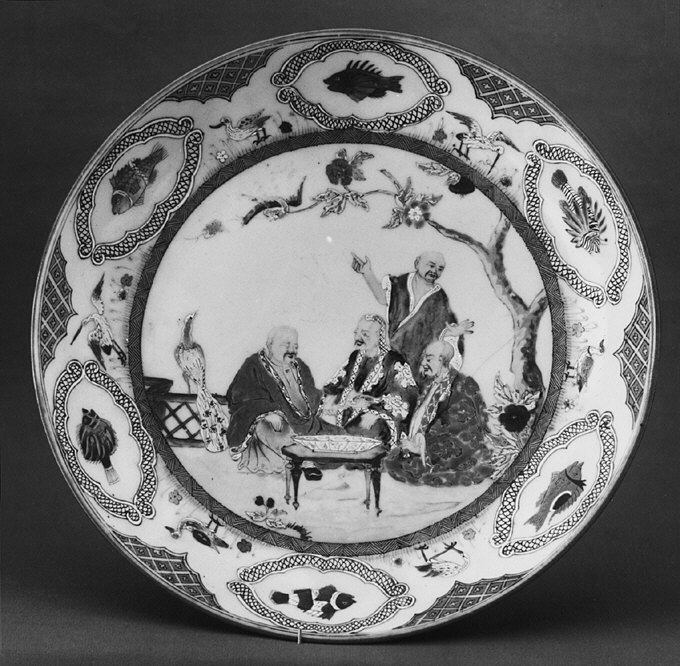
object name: dish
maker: cornelis pronk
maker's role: artist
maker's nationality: dutch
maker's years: 1691-1759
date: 1738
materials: hard paste porcelain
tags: men,peacocks,fish,trees